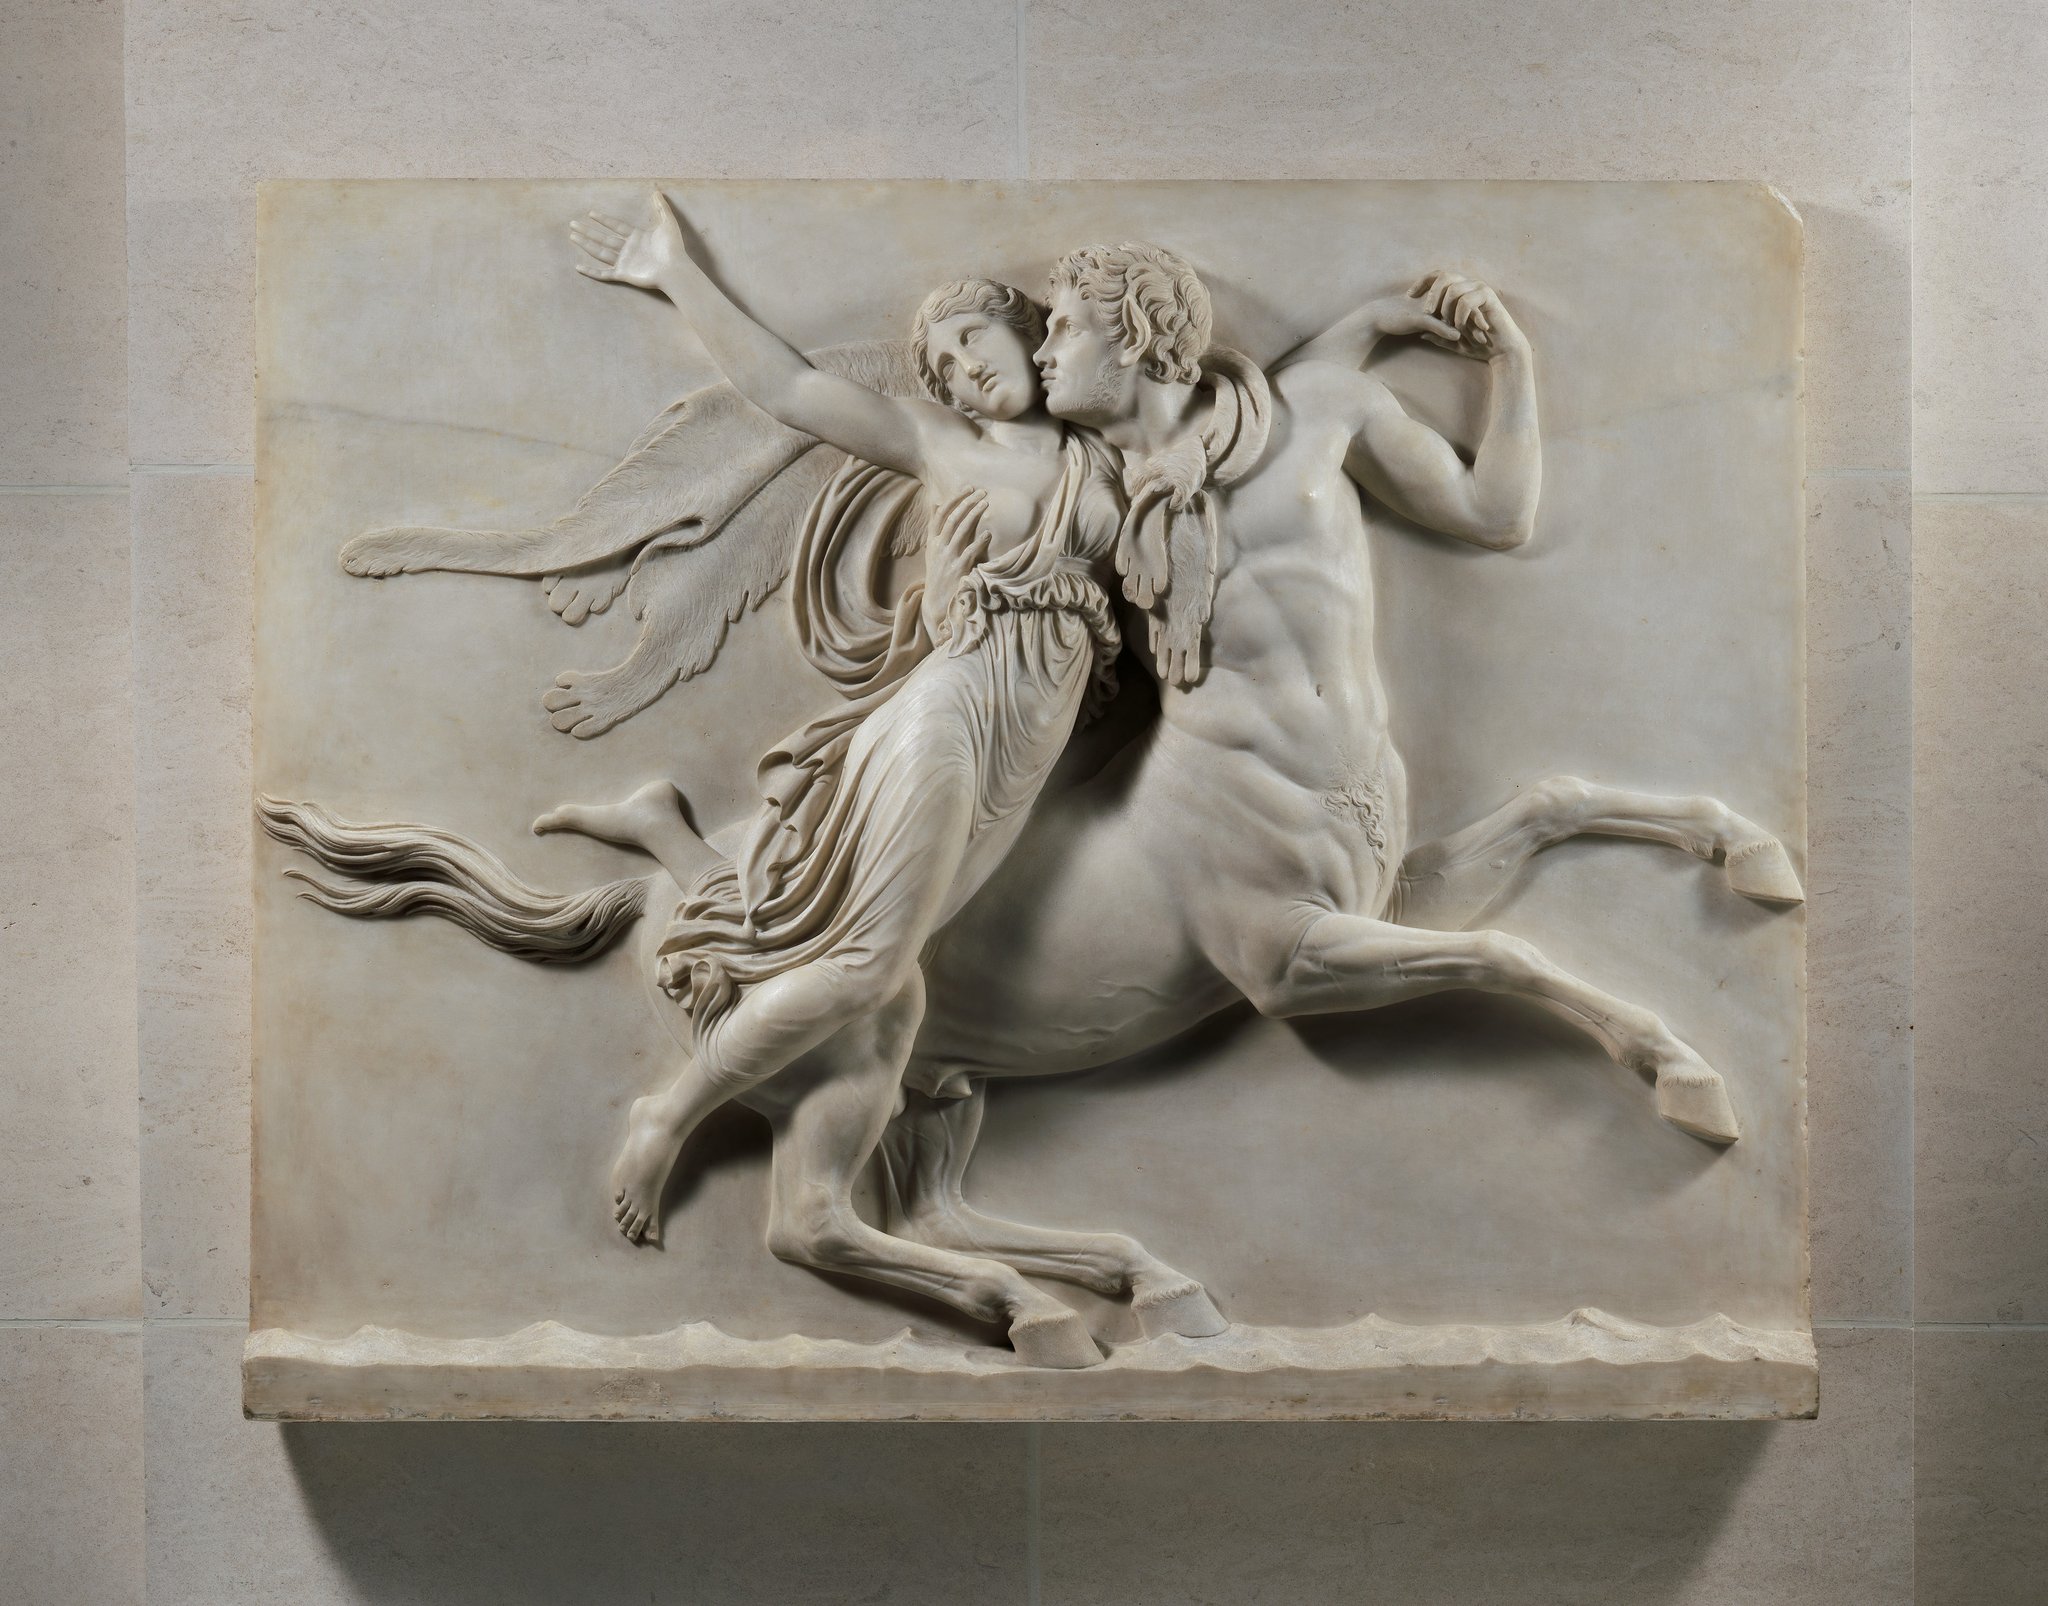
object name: relief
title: Nessus Abducting Dejanira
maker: bertel thorvaldsen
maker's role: artist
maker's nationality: danish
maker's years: 1770-1844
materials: marble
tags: women,centaurs